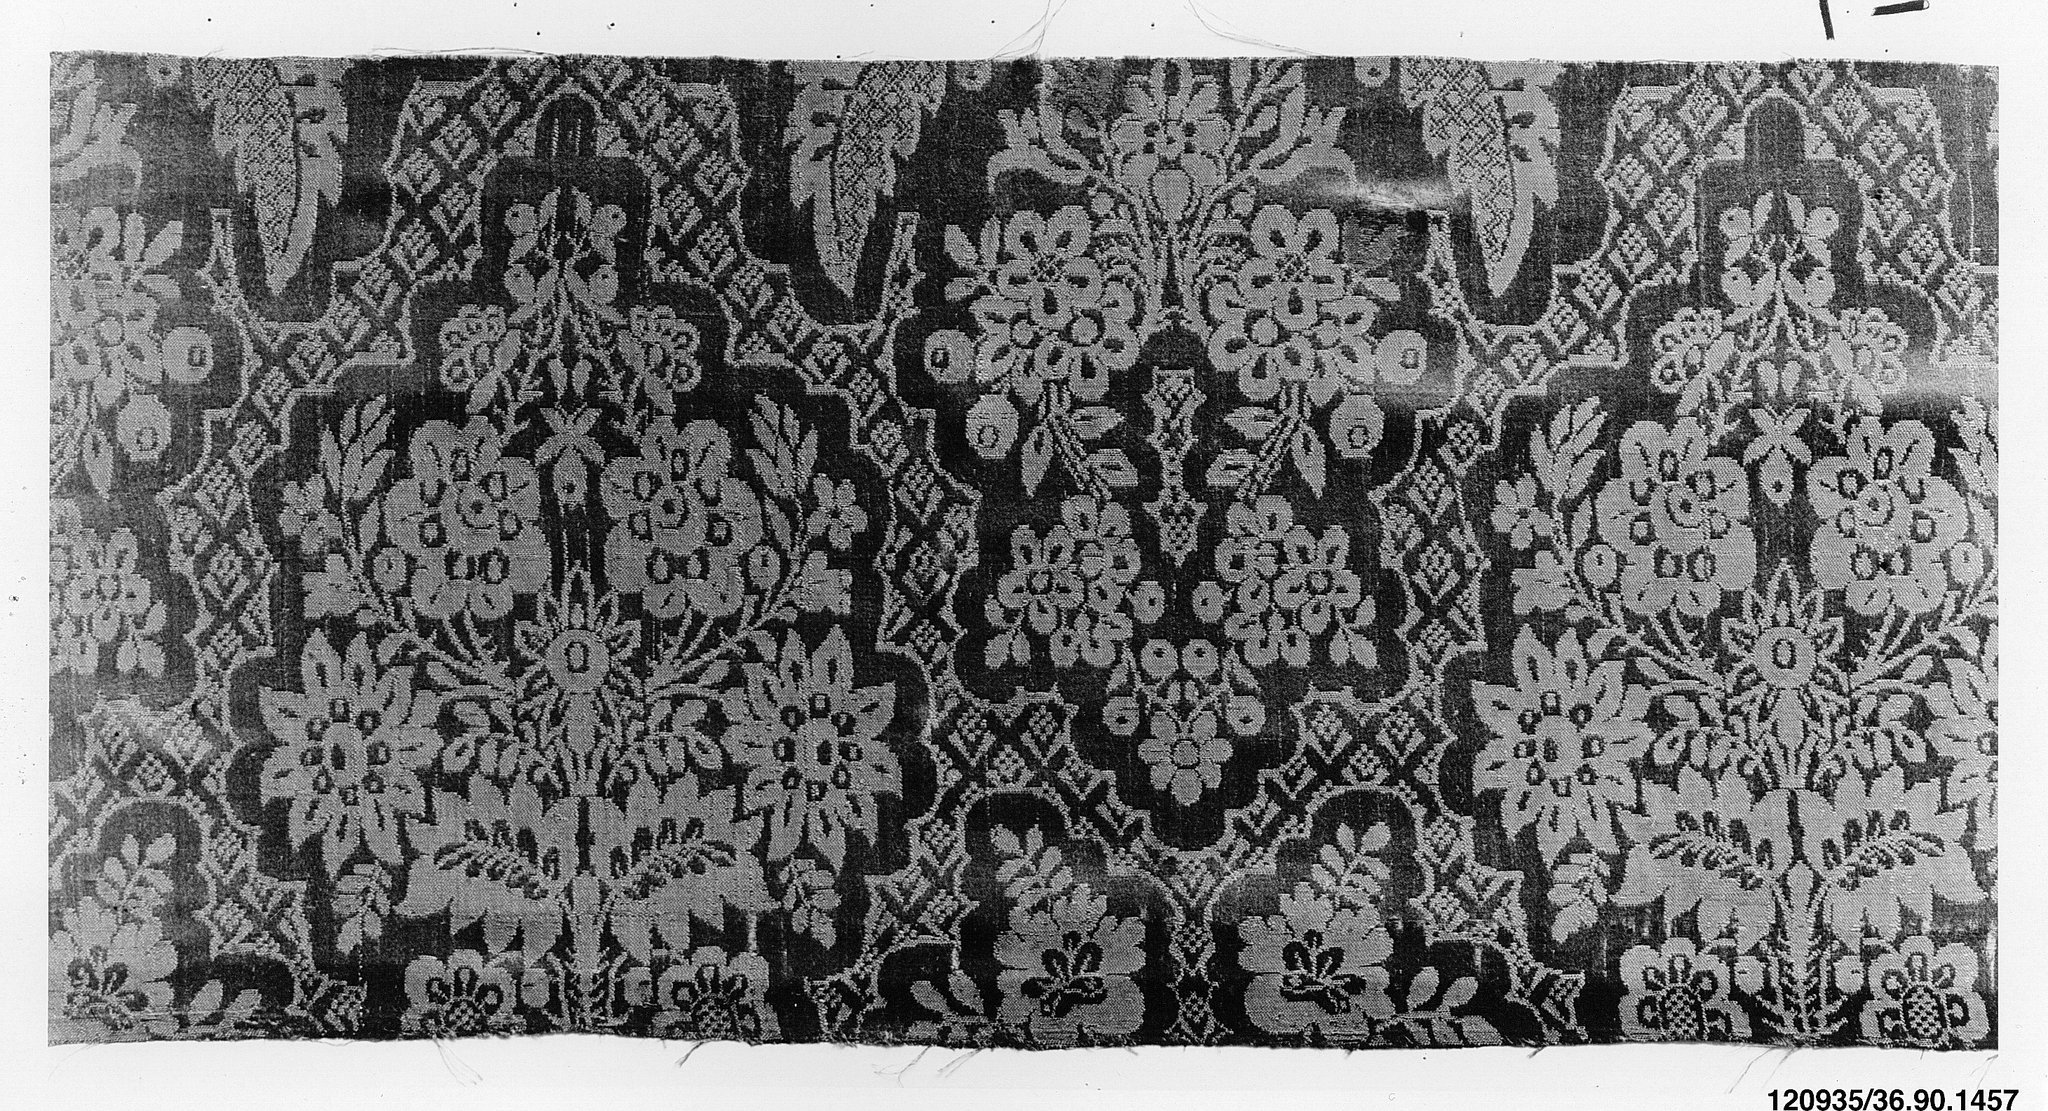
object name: piece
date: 1701-1800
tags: flowers,leaves